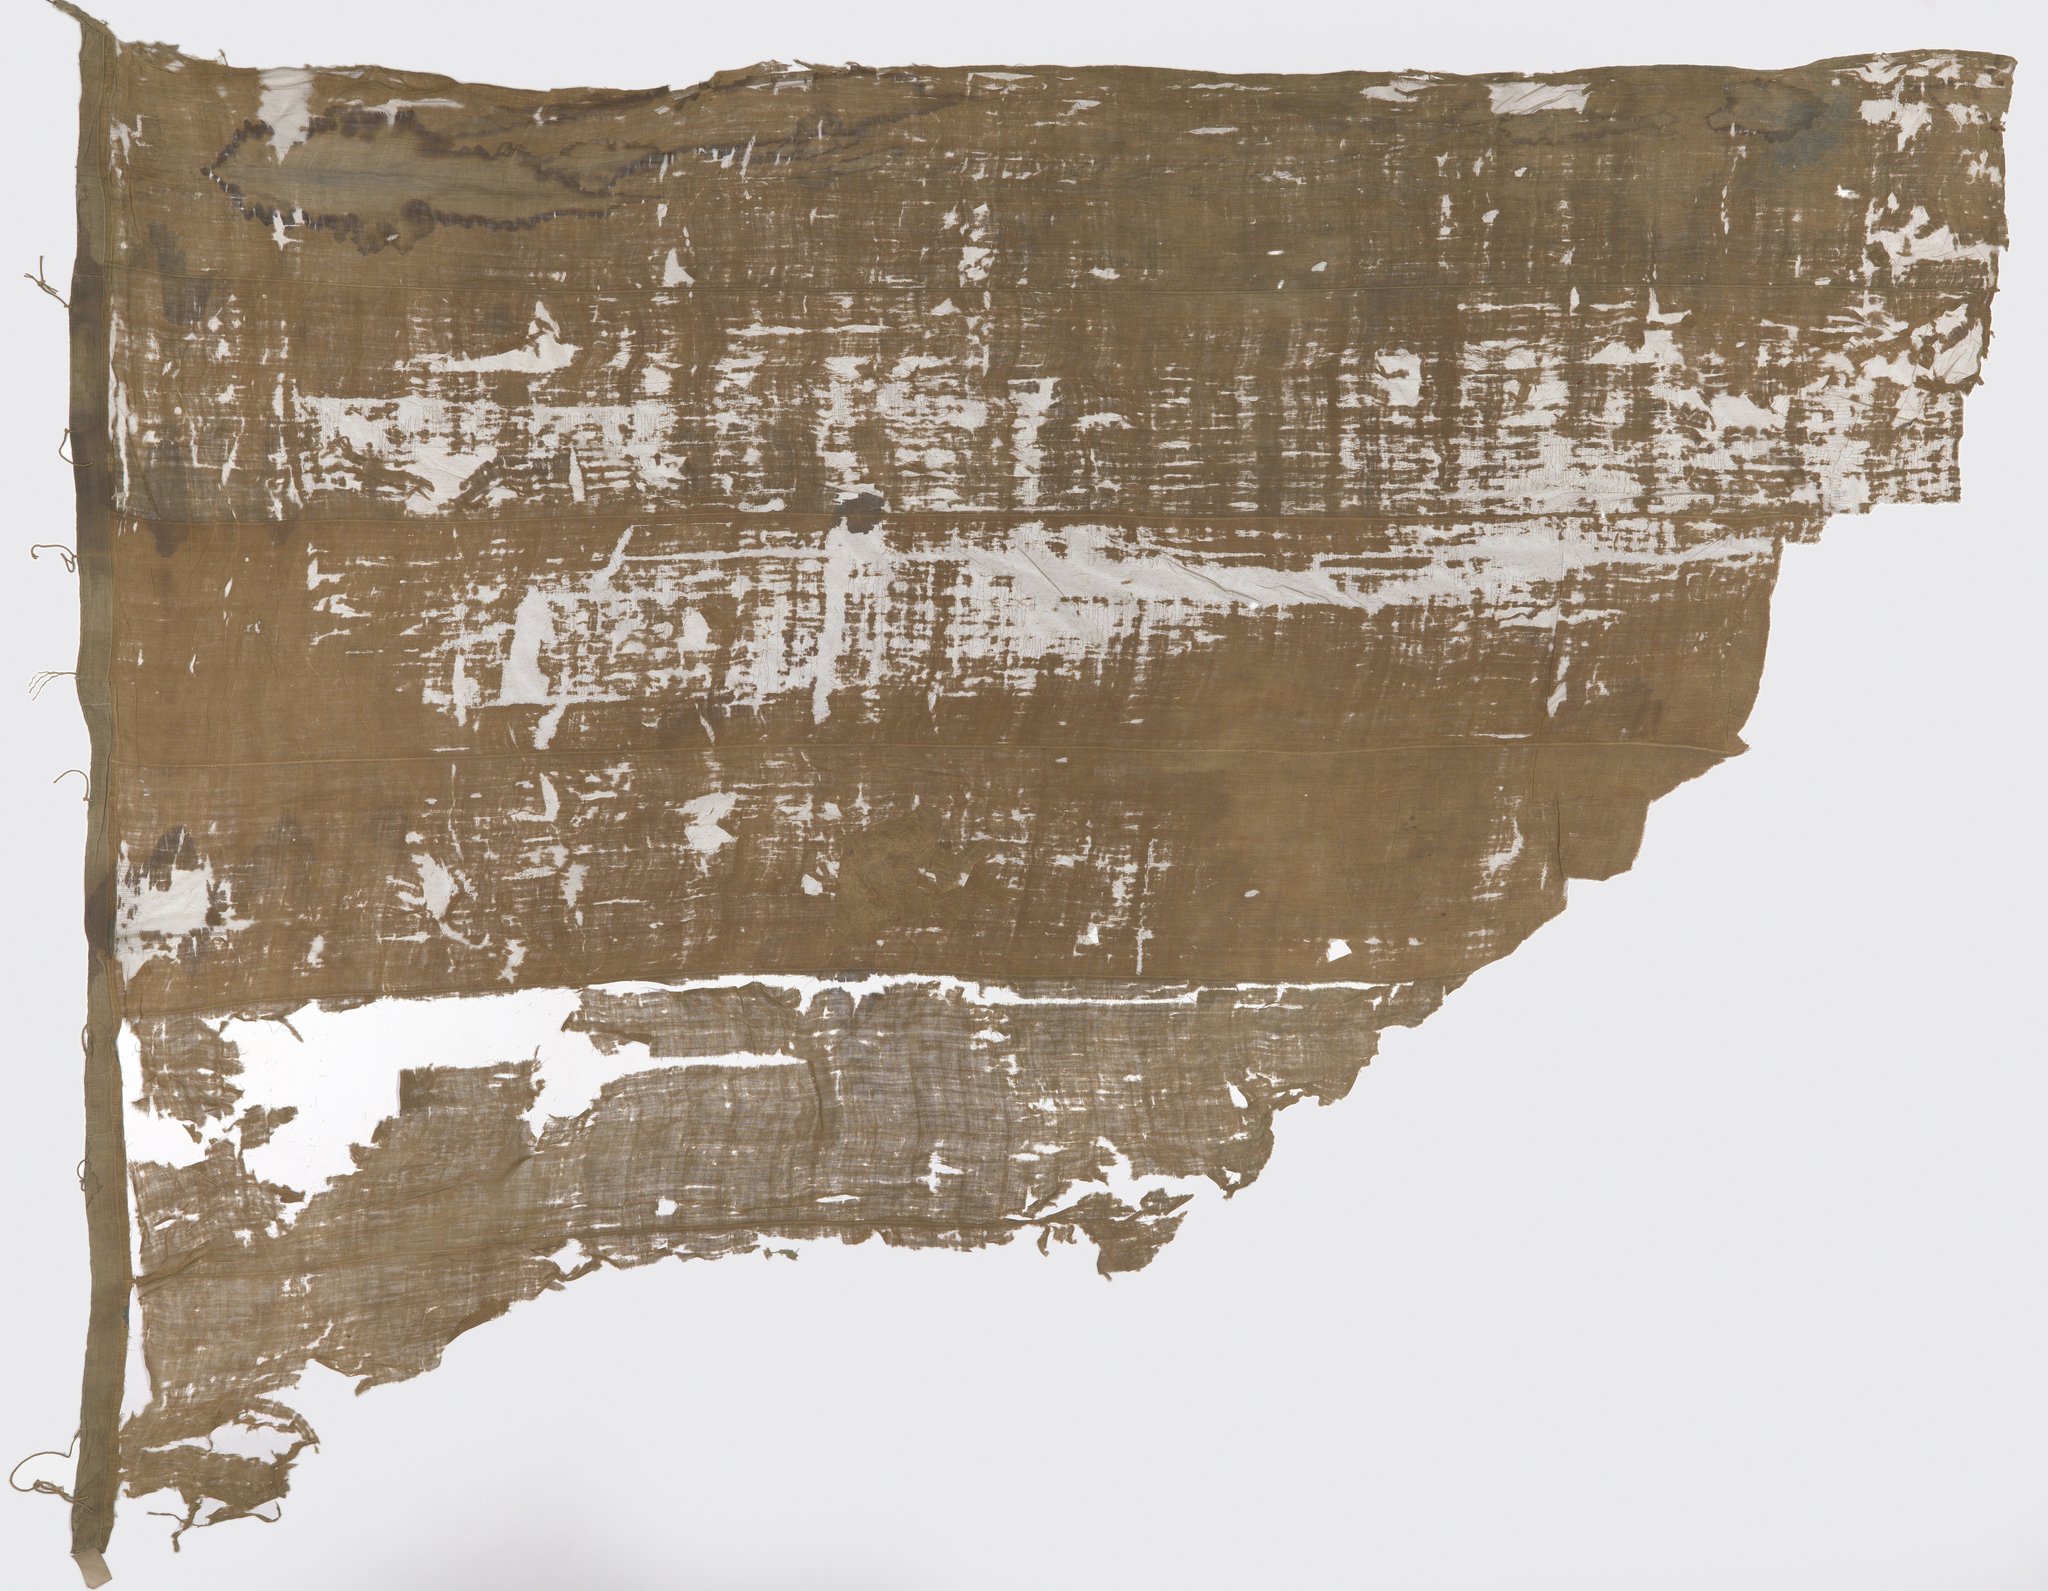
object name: flag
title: Fragment of a Flag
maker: Anonymous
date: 1600-1700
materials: linen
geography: indonesian archipelago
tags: flag, colours (as symbol of the state, etc.), dutch east indies, the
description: Groot fragment van een vlag, in slechte staat. Het is een driekleur in horizontale banen blauw-wit(?)-blauw.